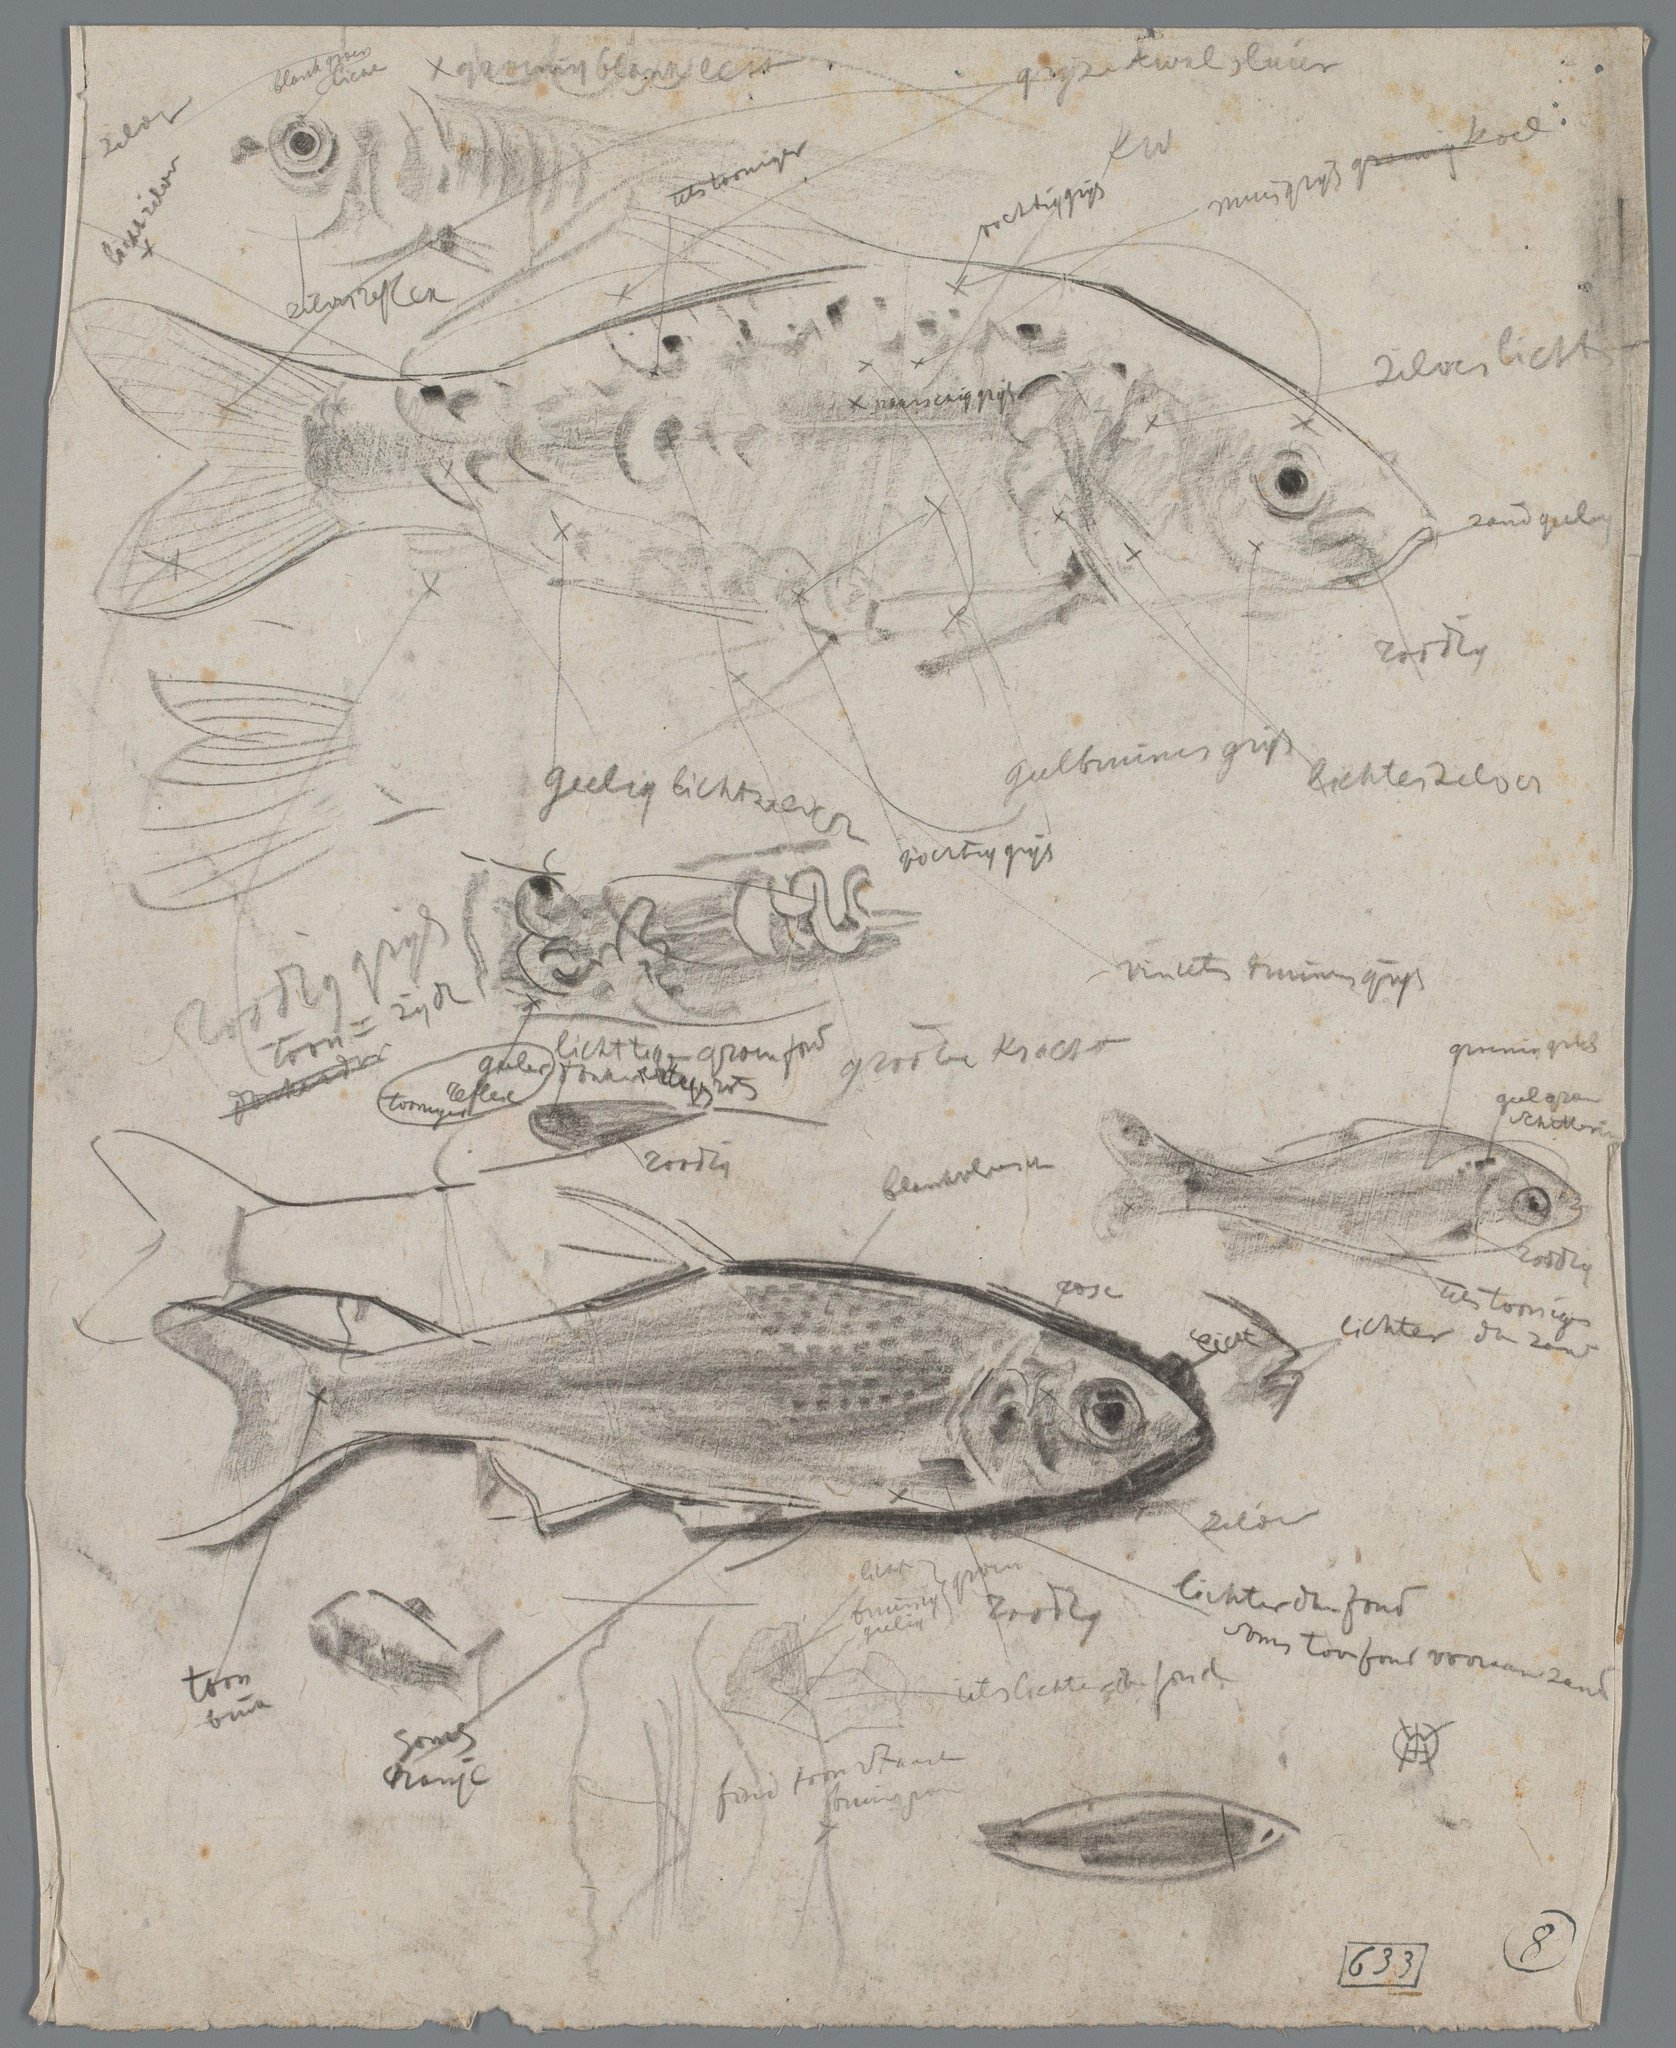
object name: drawing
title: Studies van vissen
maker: gerrit willem dijsselhof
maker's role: designer, draughtsman, print maker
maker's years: 1866-1924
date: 1876-1924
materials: chalk, paper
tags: bony fishes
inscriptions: number: ‘633’, number: ‘8’